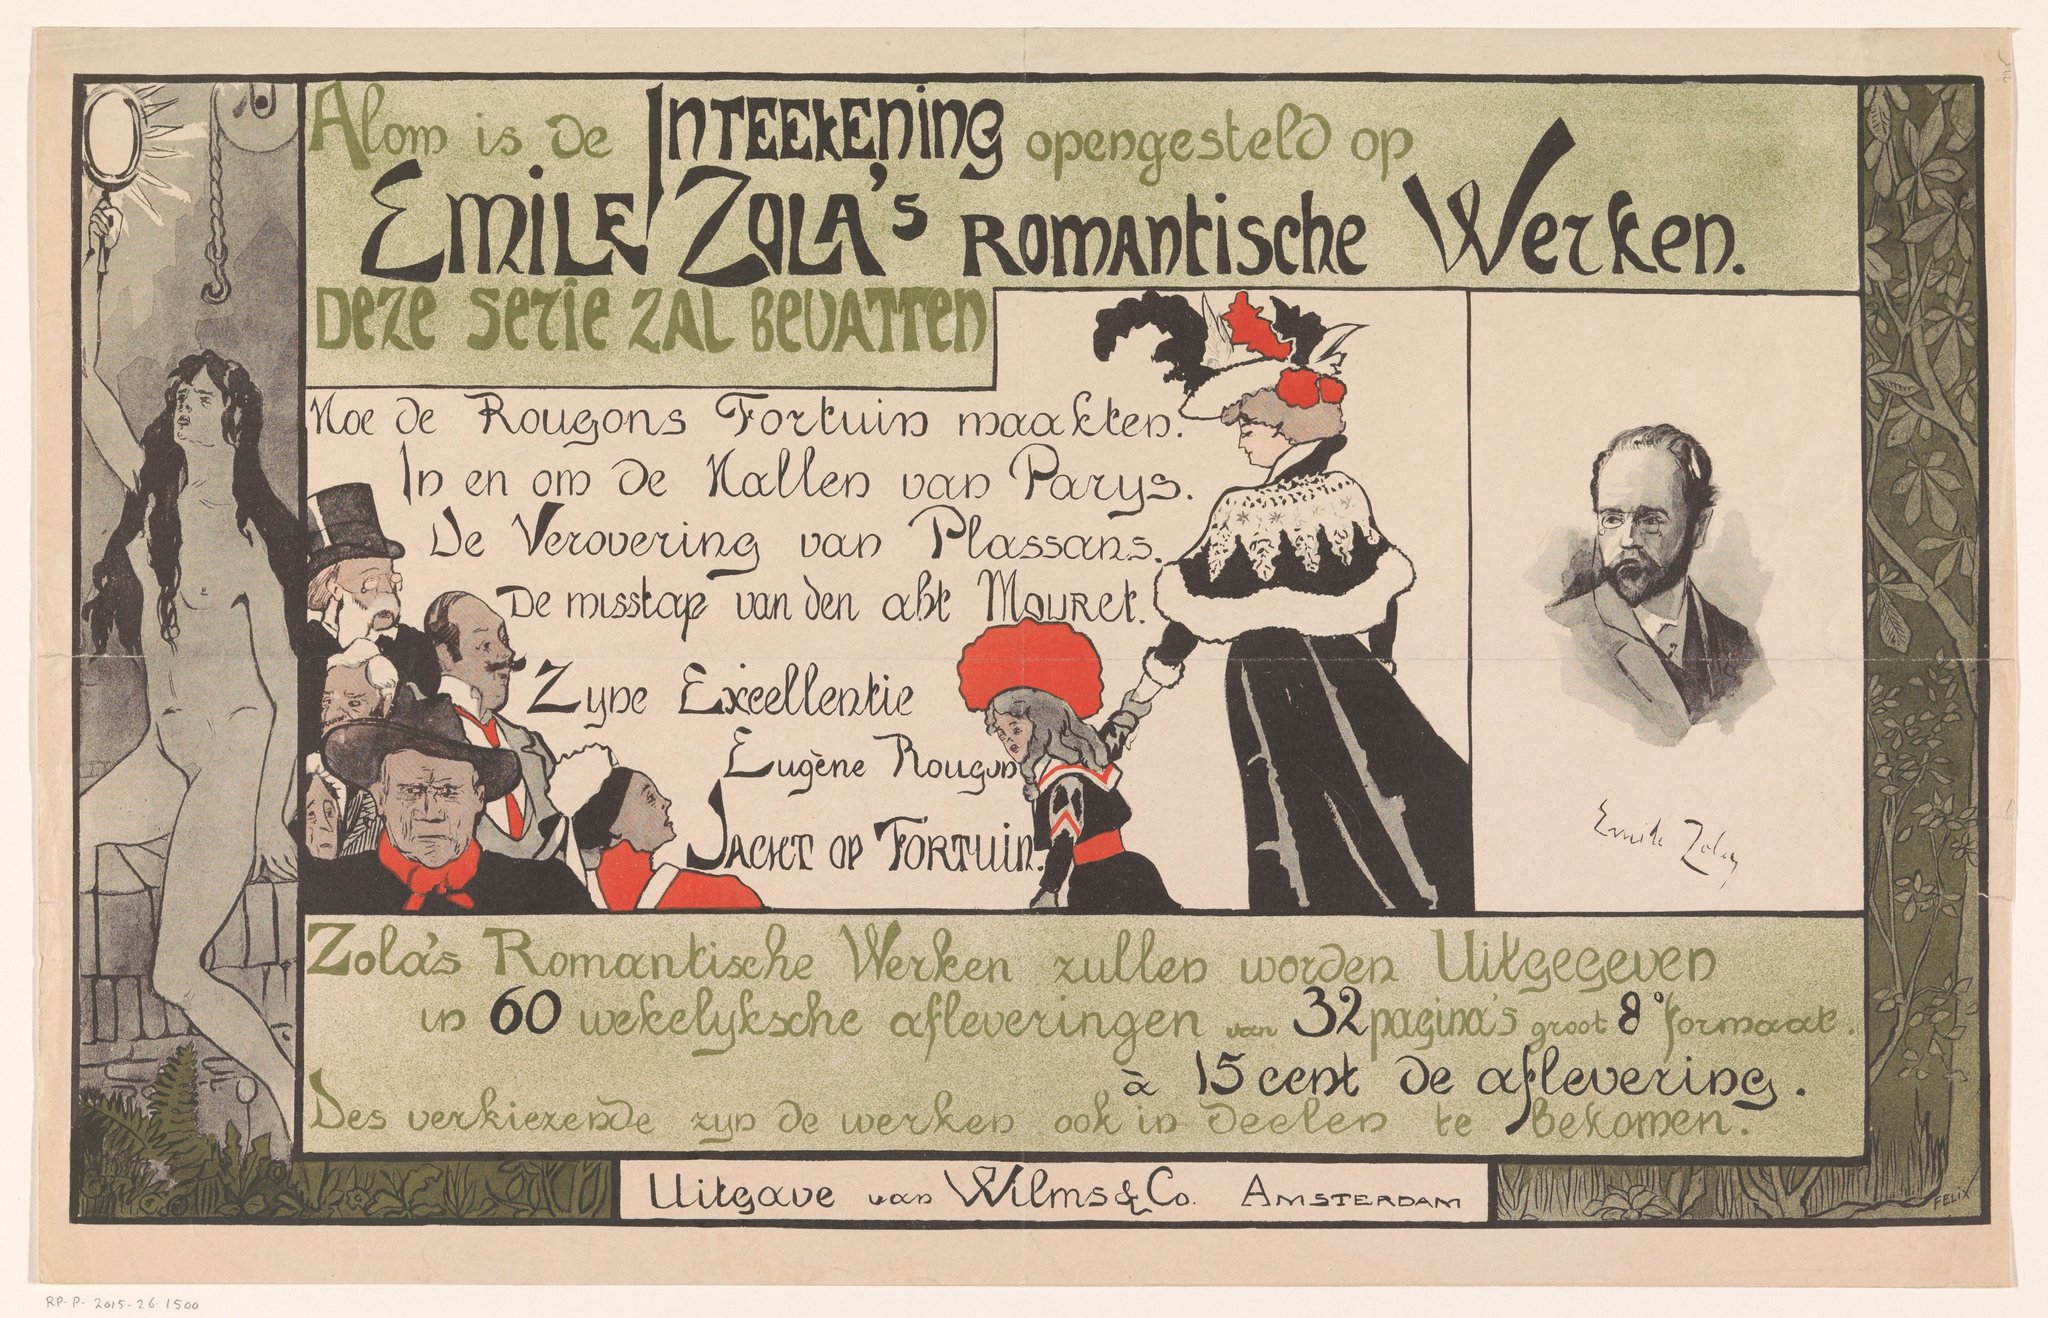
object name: reclamebiljet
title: Uitgeversprospectus voor Emile Zola's Romantische Werken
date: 1900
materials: paper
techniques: printing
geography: amsterdam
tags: paris, emile zola, well, mirror, the (nude) human figure; 'corpo humano' (ripa) - aa - female human figure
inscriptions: collector's mark: Lugt 4779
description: Links een vrouwelijk naakt op de rand van een put met een spiegel in haar hand. Boven haar hoofd hangt een katrol. In het midden een vrouw met een hoed en een meisje aan haar arm en een groep bestaand uit zes mannen en vrouwen. Rechts een portret van Emile Zola.